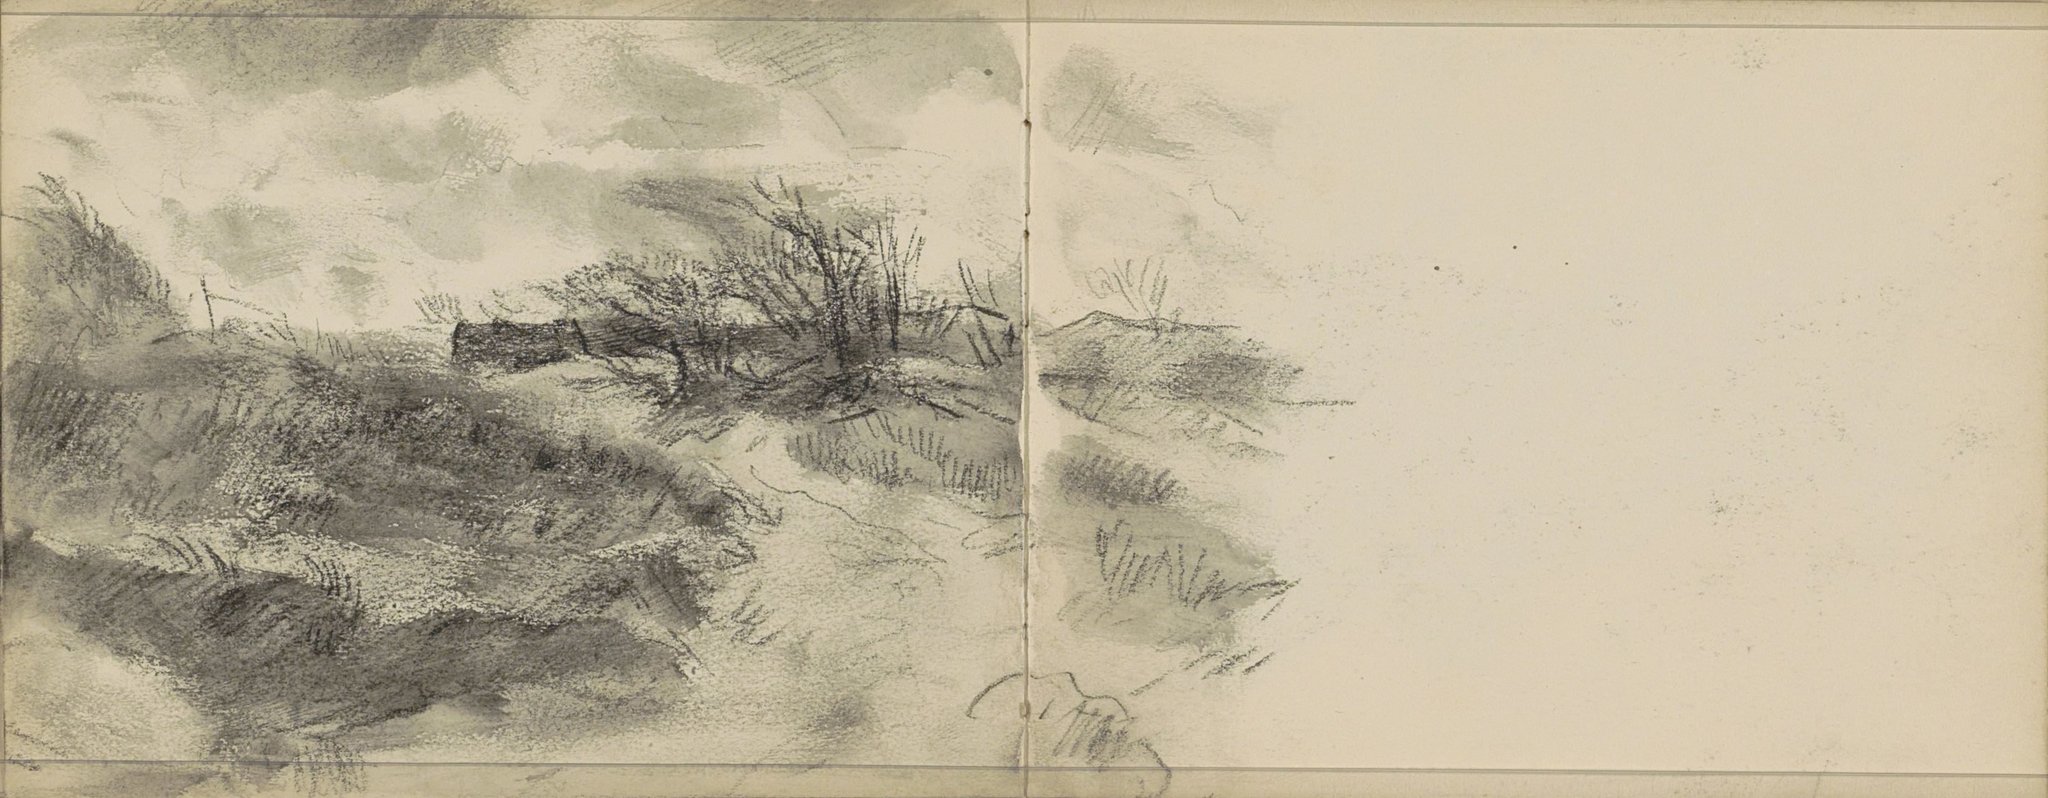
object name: sketchbook leaf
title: Landschap, mogelijk een duinlandschap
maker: johan antonie de jonge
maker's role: draughtsman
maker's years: 1864-1927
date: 1881-1927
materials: chalk, paper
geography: south holland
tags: dune coast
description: Landschap, mogelijk een duinlandschap. Blad 31 verso en blad 32 recto uit een schetsboek met 34 bladen.